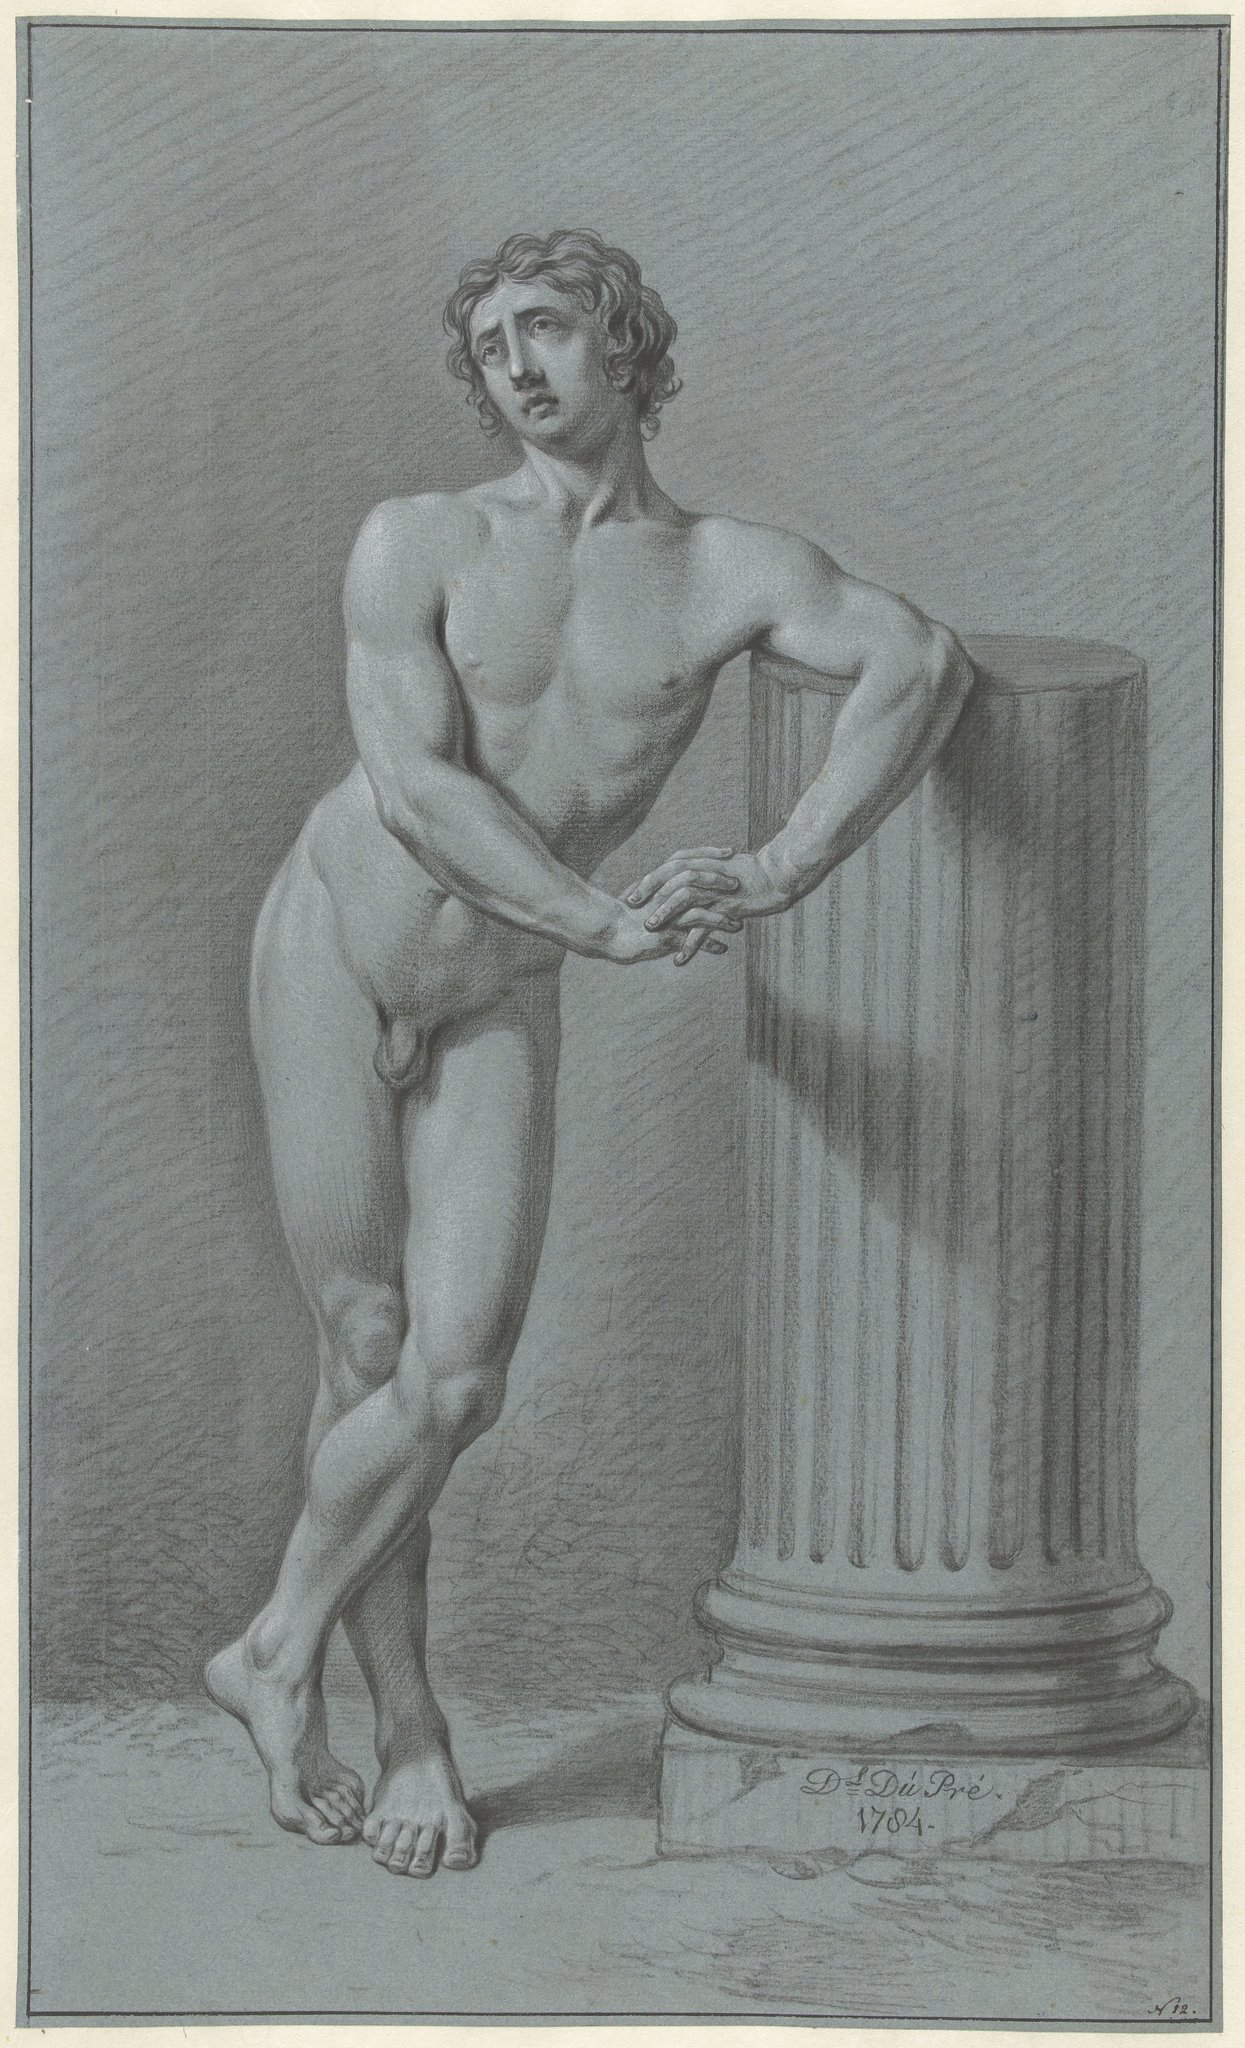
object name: drawing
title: Staand mannelijk naakt, leunend tegen afgebroken zuil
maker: daniël dupré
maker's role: draughtsman, print maker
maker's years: 1751-1817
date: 1784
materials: chalk, paper